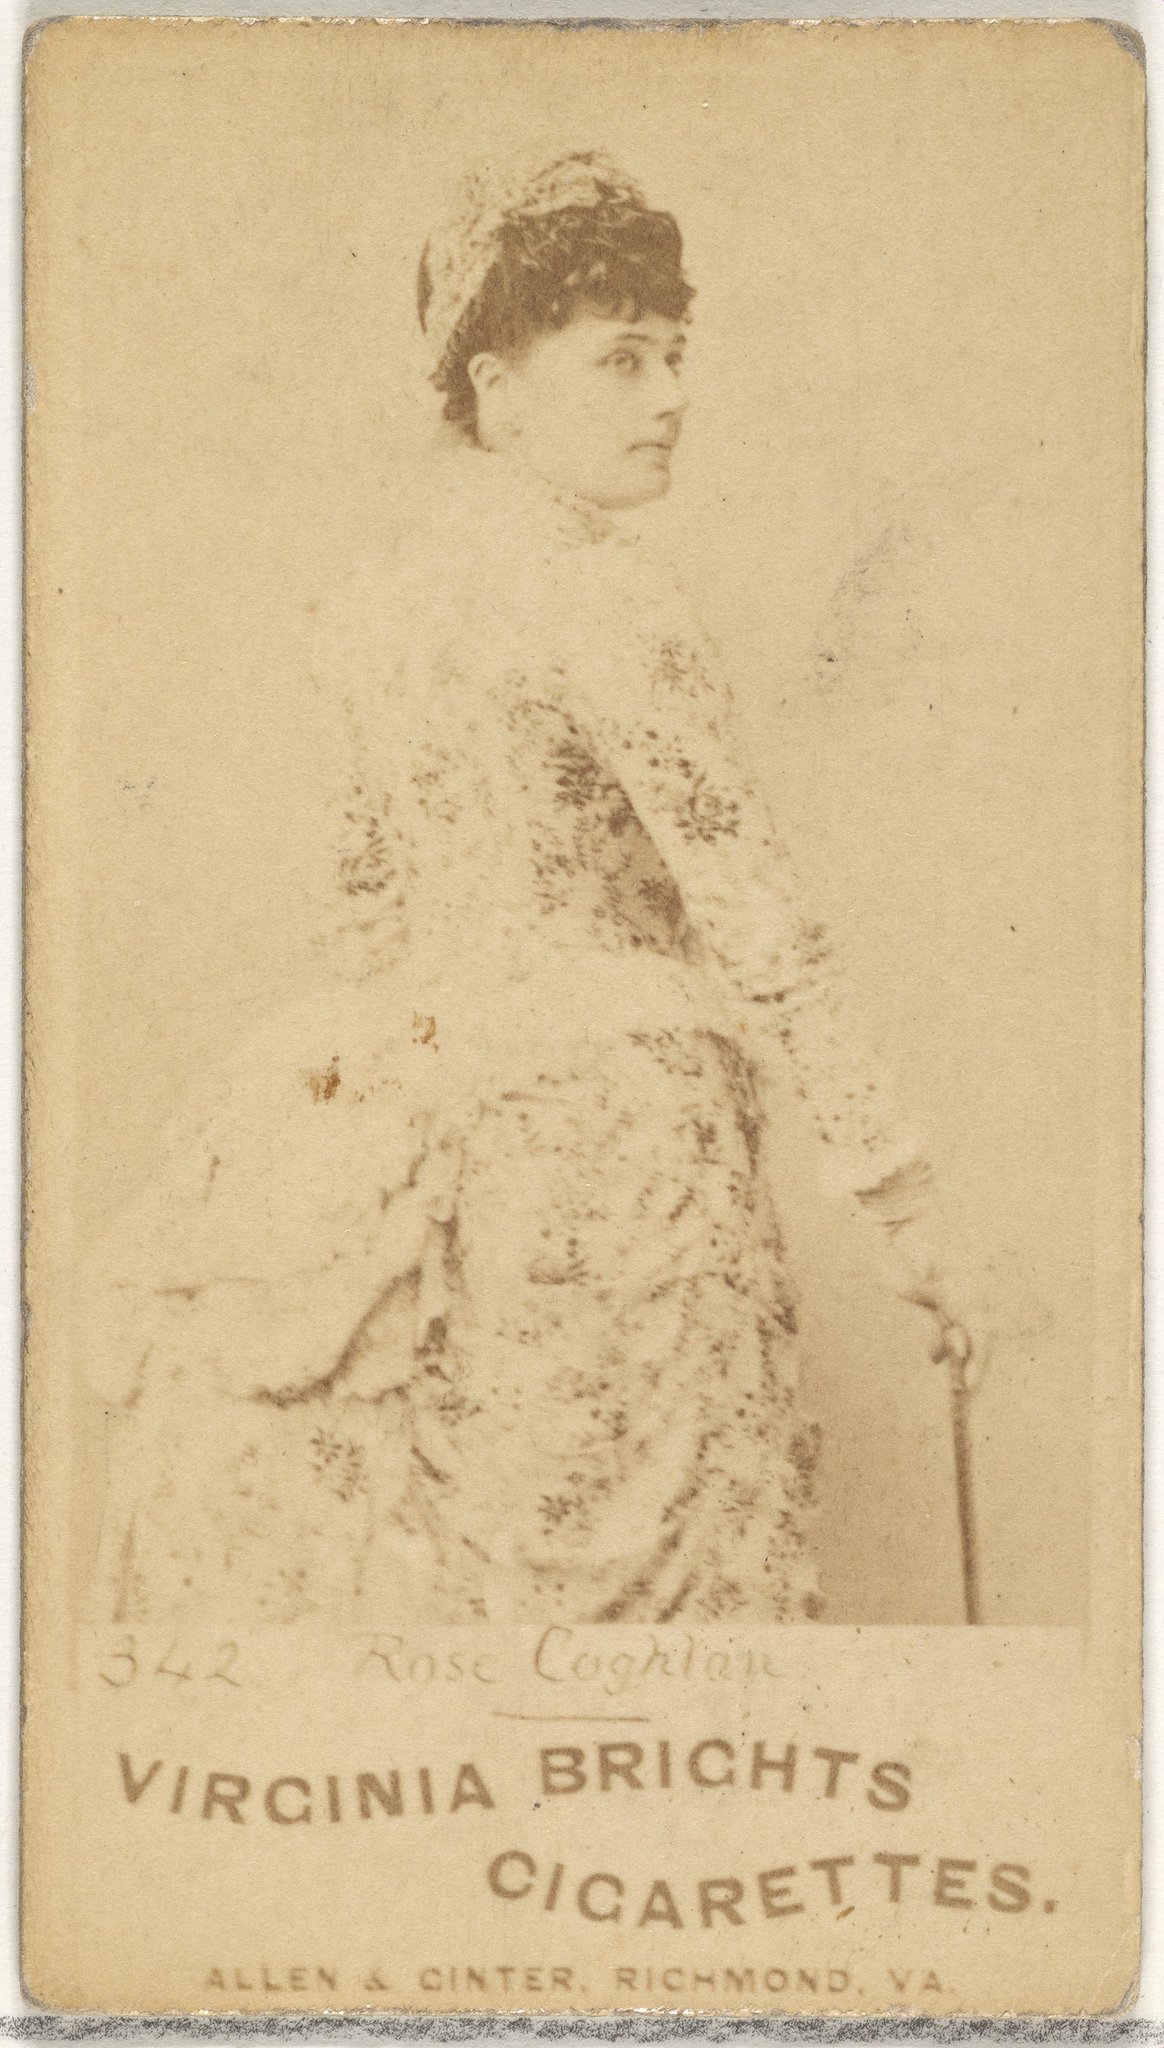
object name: photograph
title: Card 342, Rose Coghlan, from the Actors and Actresses series (N45, Type 1) for Virginia Brights Cigarettes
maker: allen & ginter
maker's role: publisher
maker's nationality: american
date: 1888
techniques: albumen silver print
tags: portraits,women,actresses